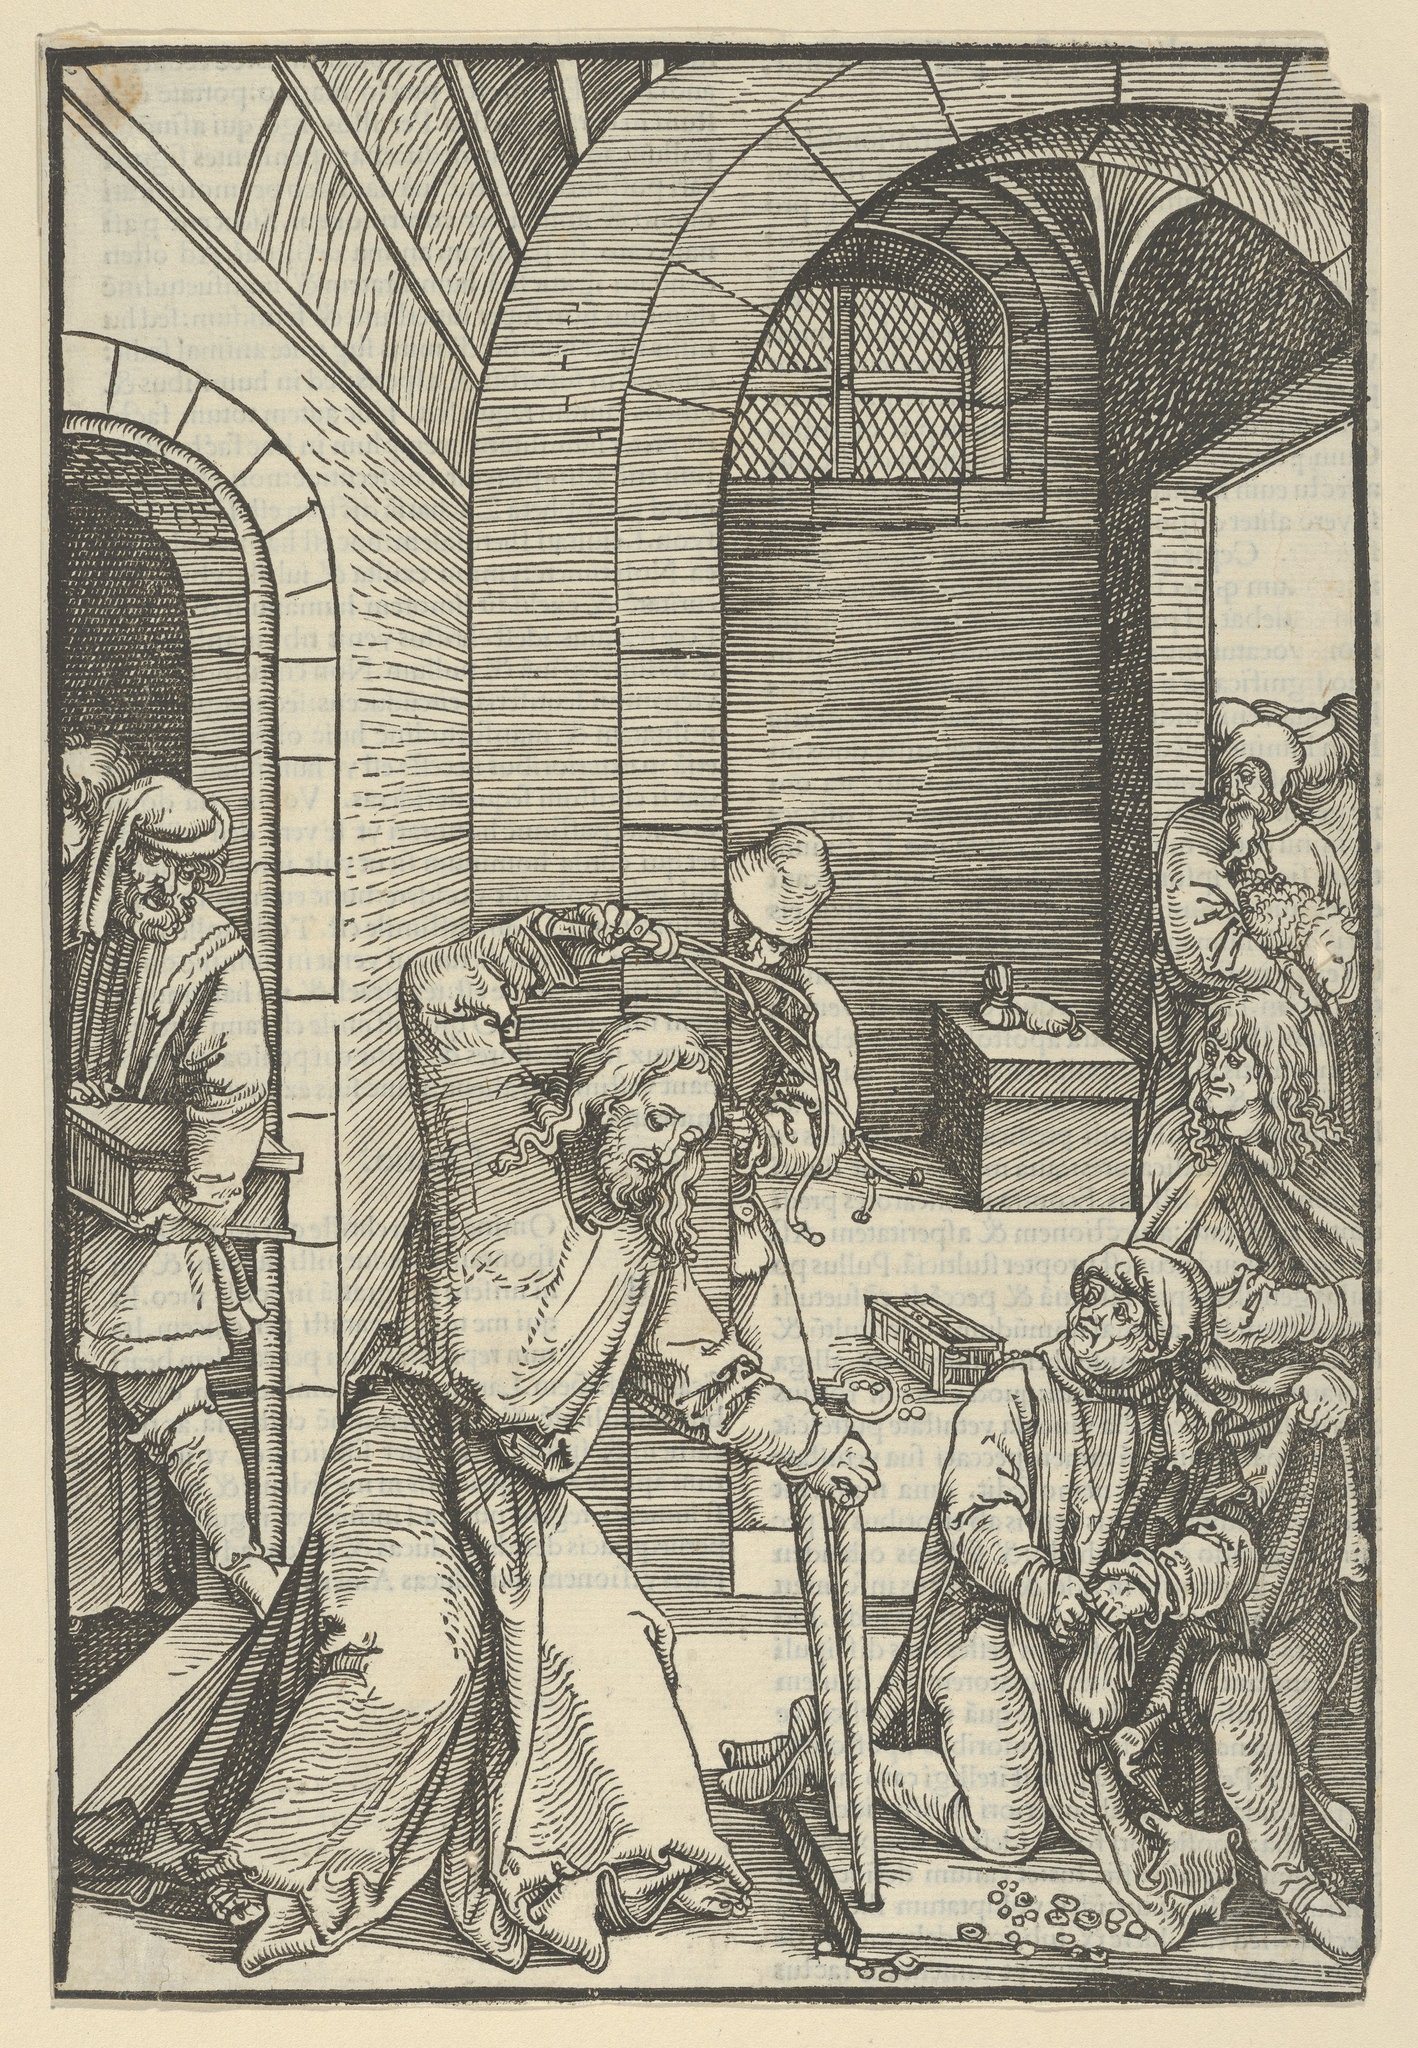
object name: print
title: Christ Purifying the Temple, from Speculum passionis domini nostri Ihesu Christi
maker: hans schäufelein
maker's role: artist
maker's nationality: german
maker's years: 1480-1540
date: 1507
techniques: woodcut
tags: men,women,christ